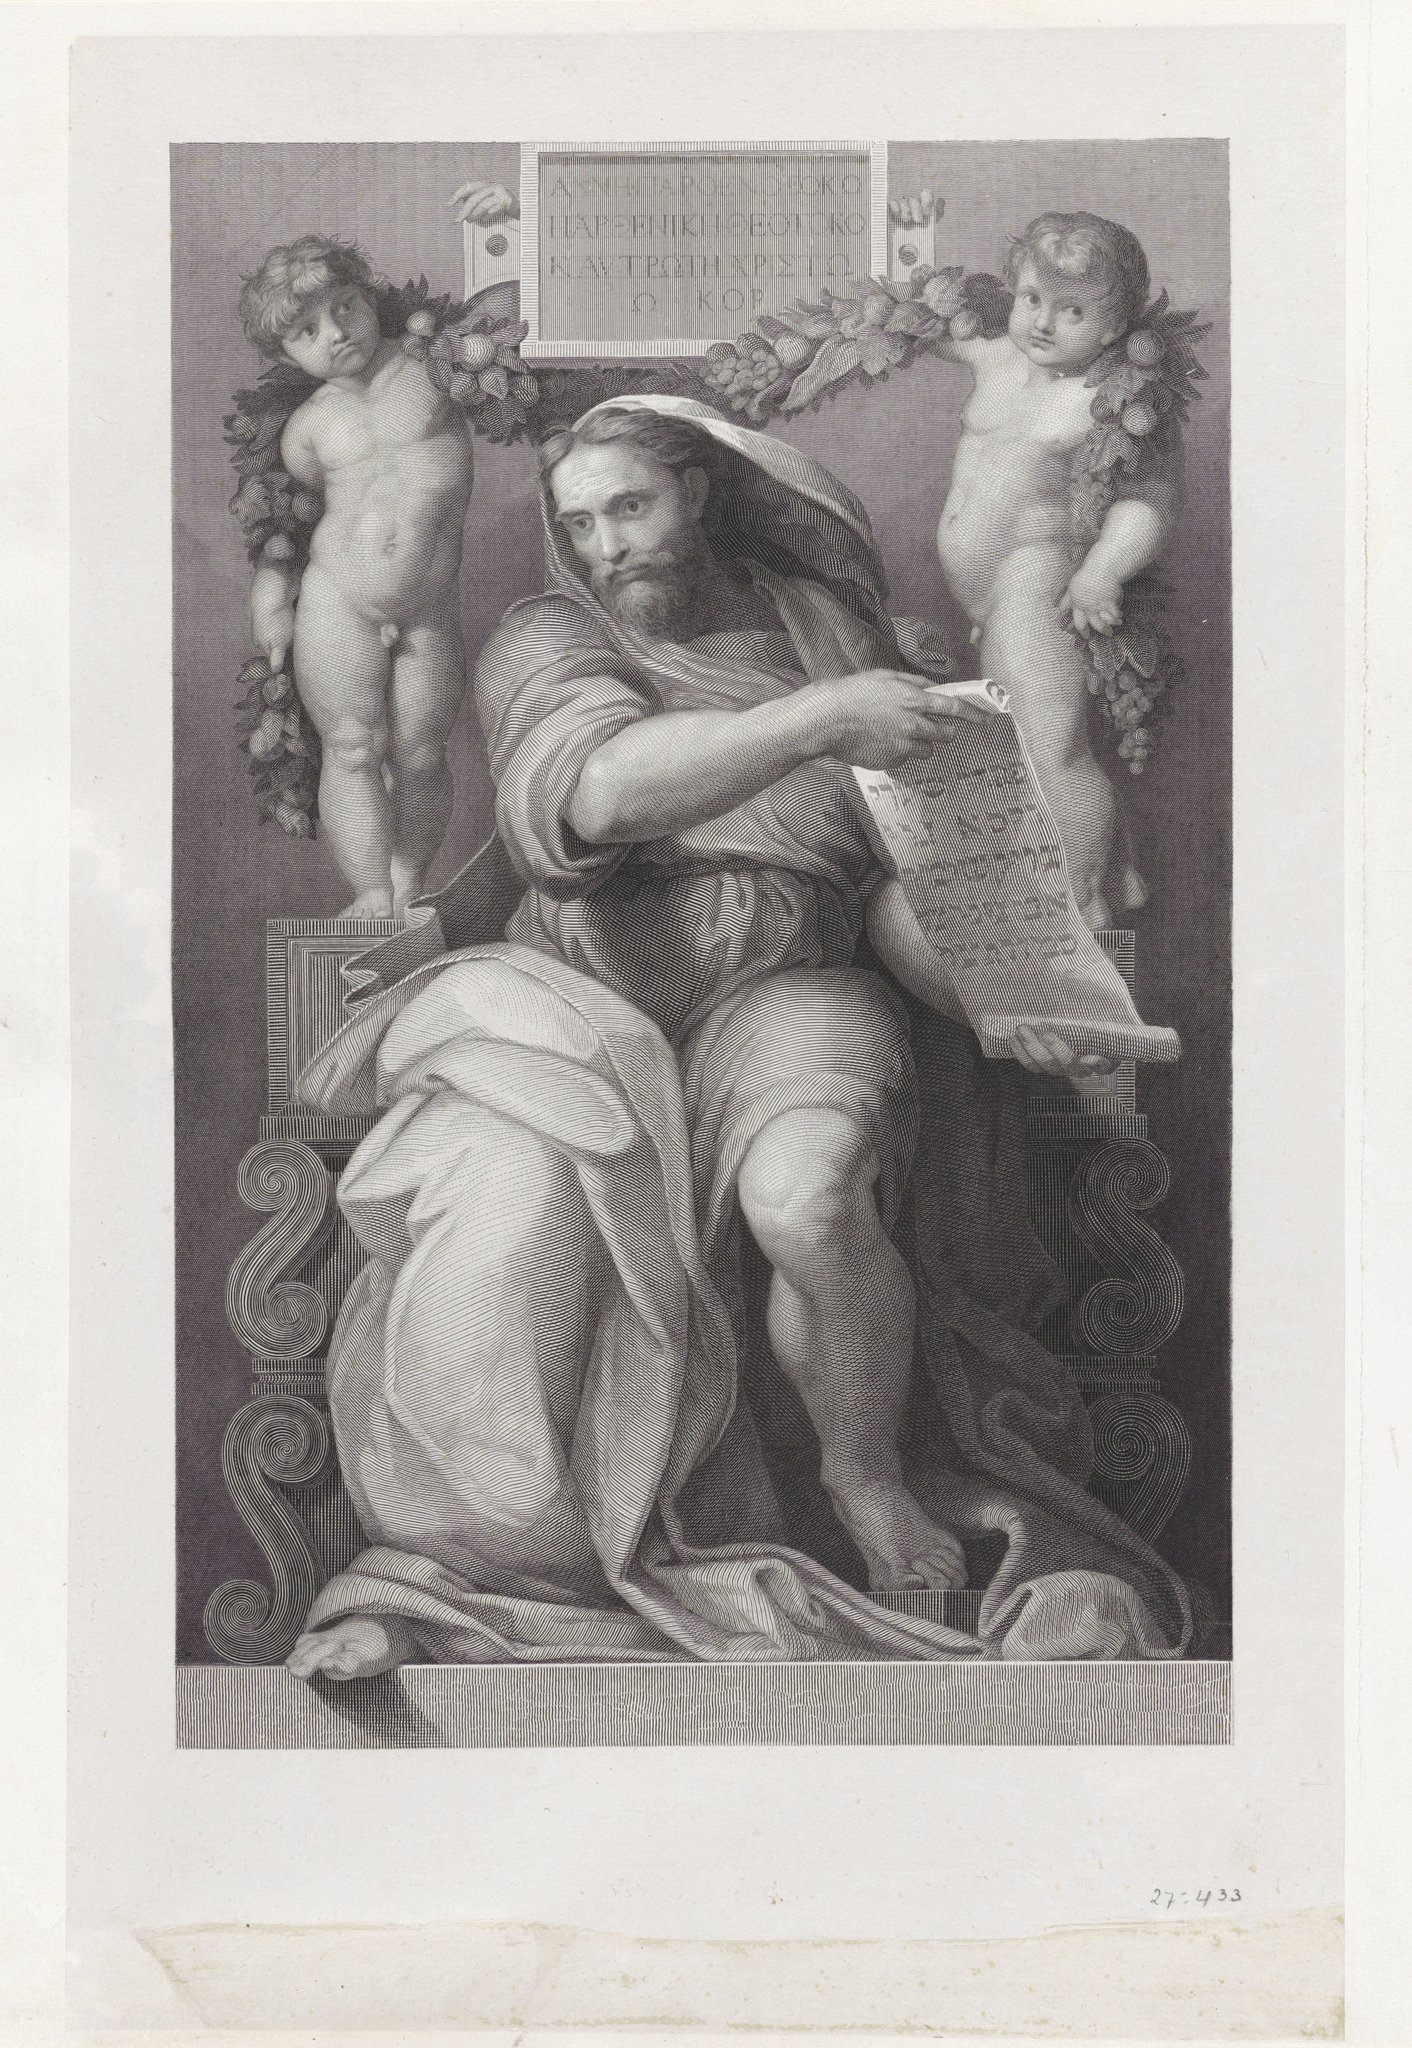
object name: print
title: Profeet Jesaja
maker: benoit taurel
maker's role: draughtsman, print maker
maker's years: 1794-1859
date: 1804-1859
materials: paper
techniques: engraving, etching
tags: the book of isaiah (+ variant), ornament ~ festoon, garland, cupids: 'amores', 'amoretti', 'putti'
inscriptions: collector's mark: Lugt 2228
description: De profeet Jesaja, met een rol met een Hebreeuwse tekst in zijn handen. Achter hem twee putti met een bloemguirlande, die een tablet ophouden met een tekst in het Grieks.